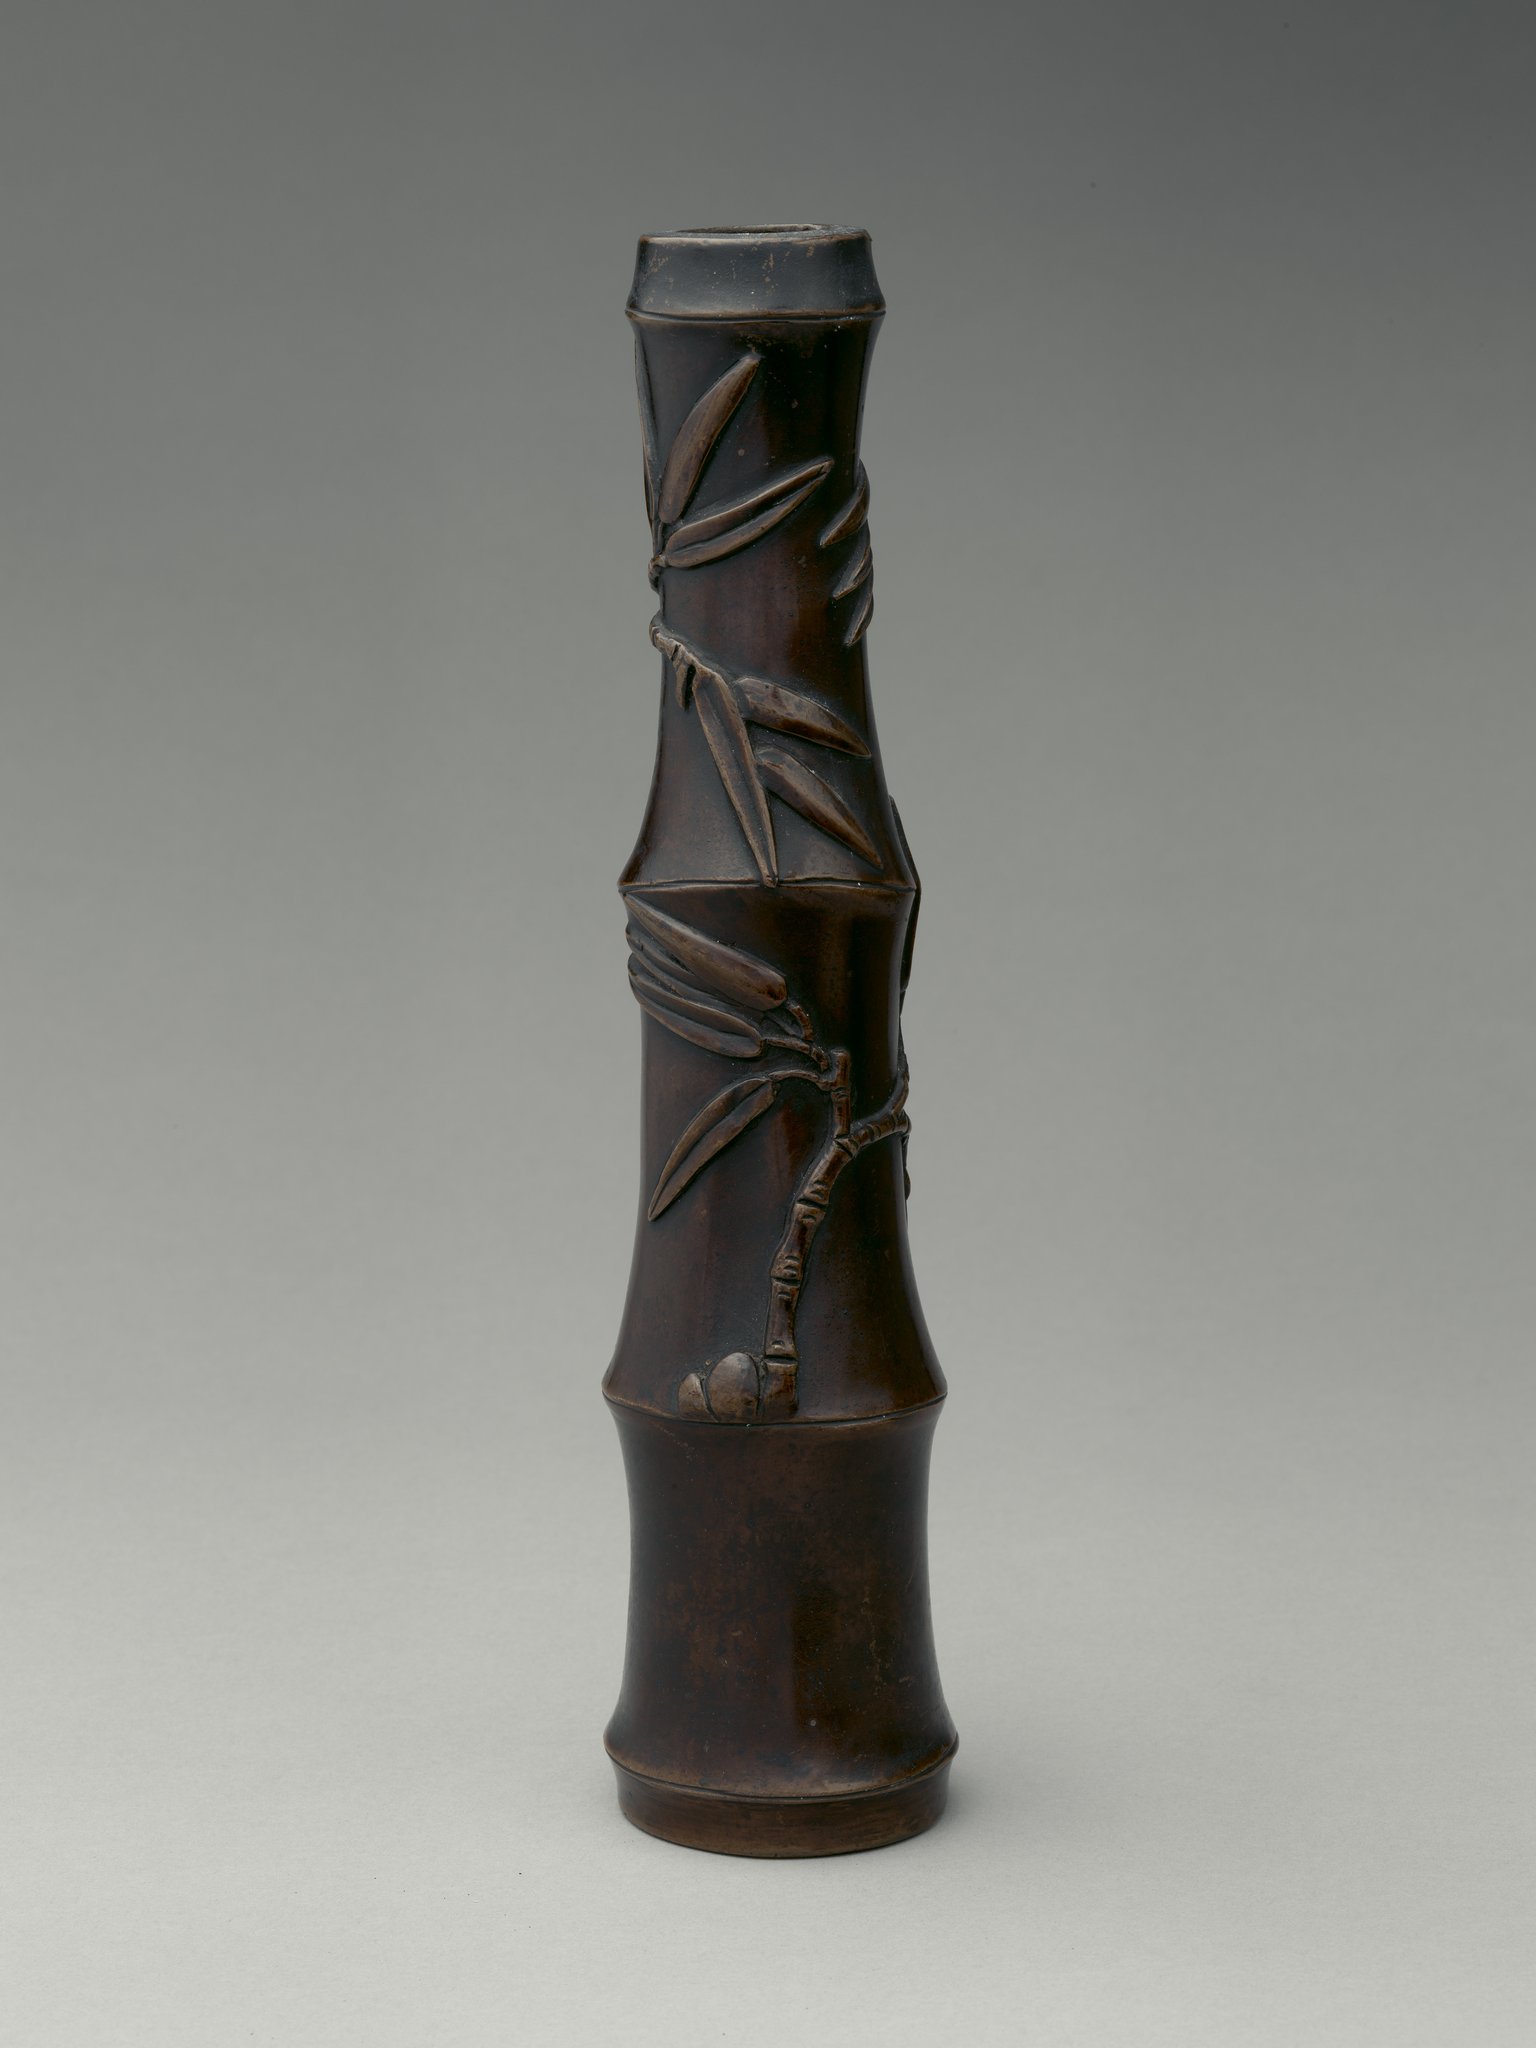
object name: candlestick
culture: japanese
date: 1851-1900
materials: copper alloy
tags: bamboo